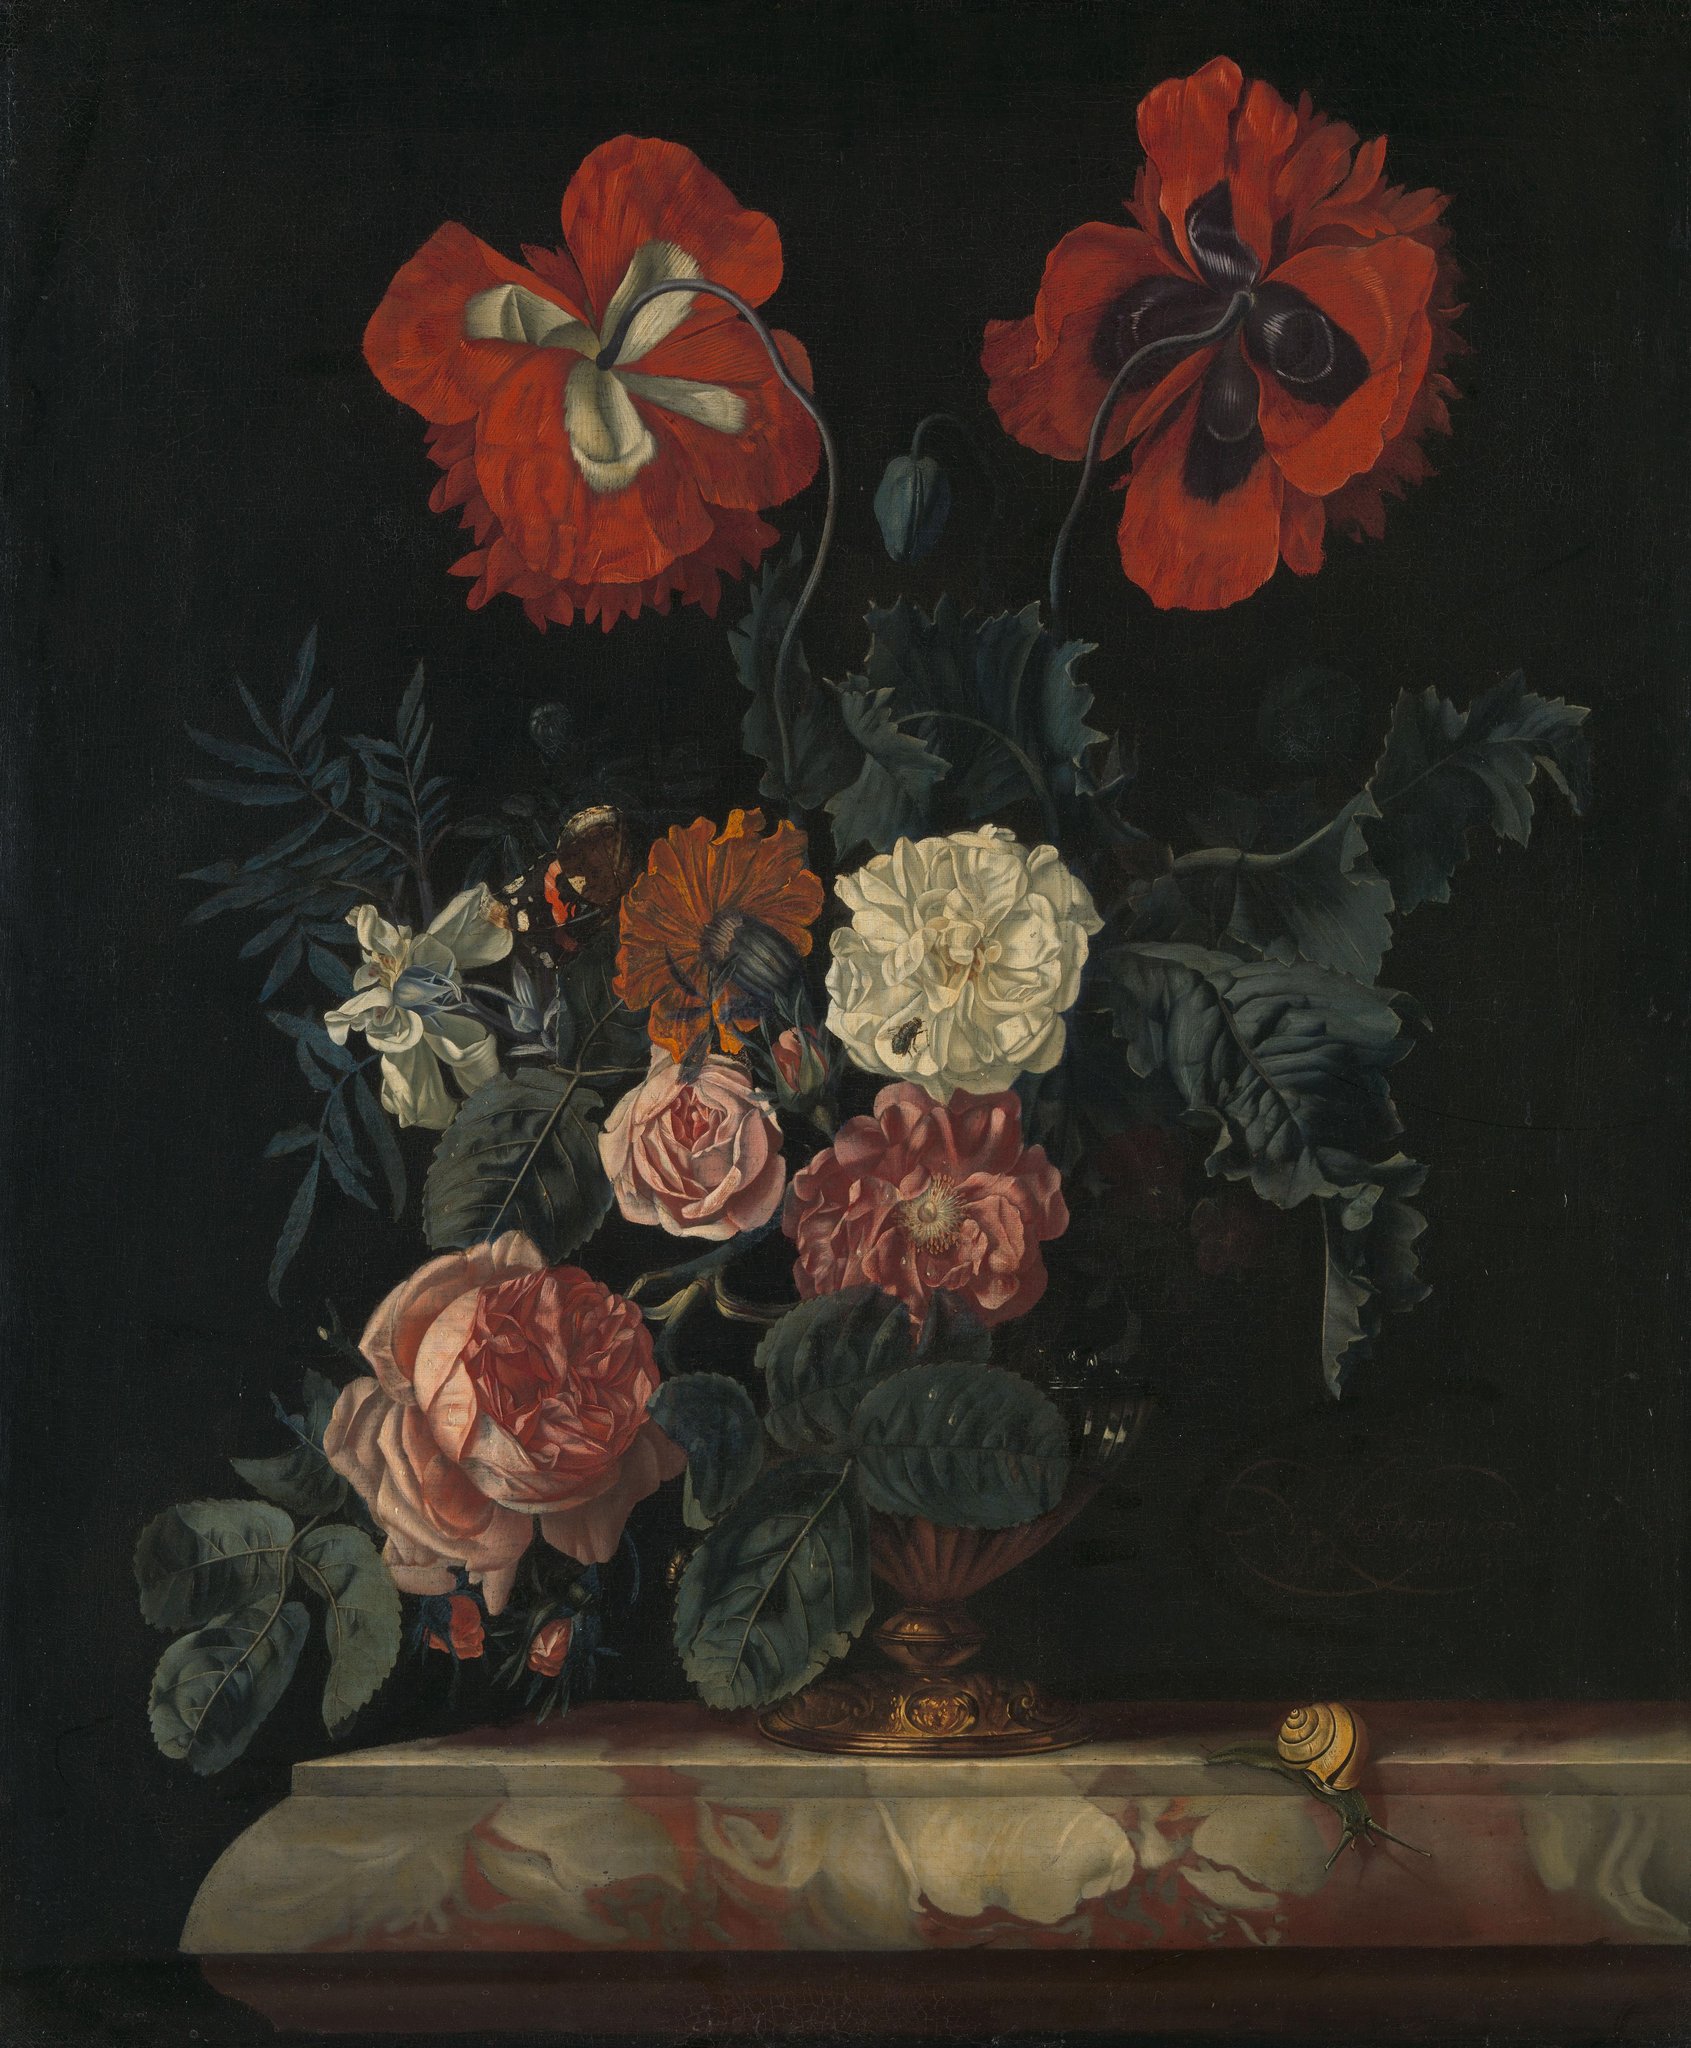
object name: painting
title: Still Life with Flowers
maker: nicolaes lachtropius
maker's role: painter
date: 1667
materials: canvas, oil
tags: cut flowers; nosegay, bunch of flowers, flowers in a vase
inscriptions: signature and date: ‘N. Lachtropius Anº 1667’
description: Bloemstilleven. Op een marmeren plint een vaas met een boeket met rozen en papavers. Tussen de bloemen enkele vlinders, op de plint een slak.